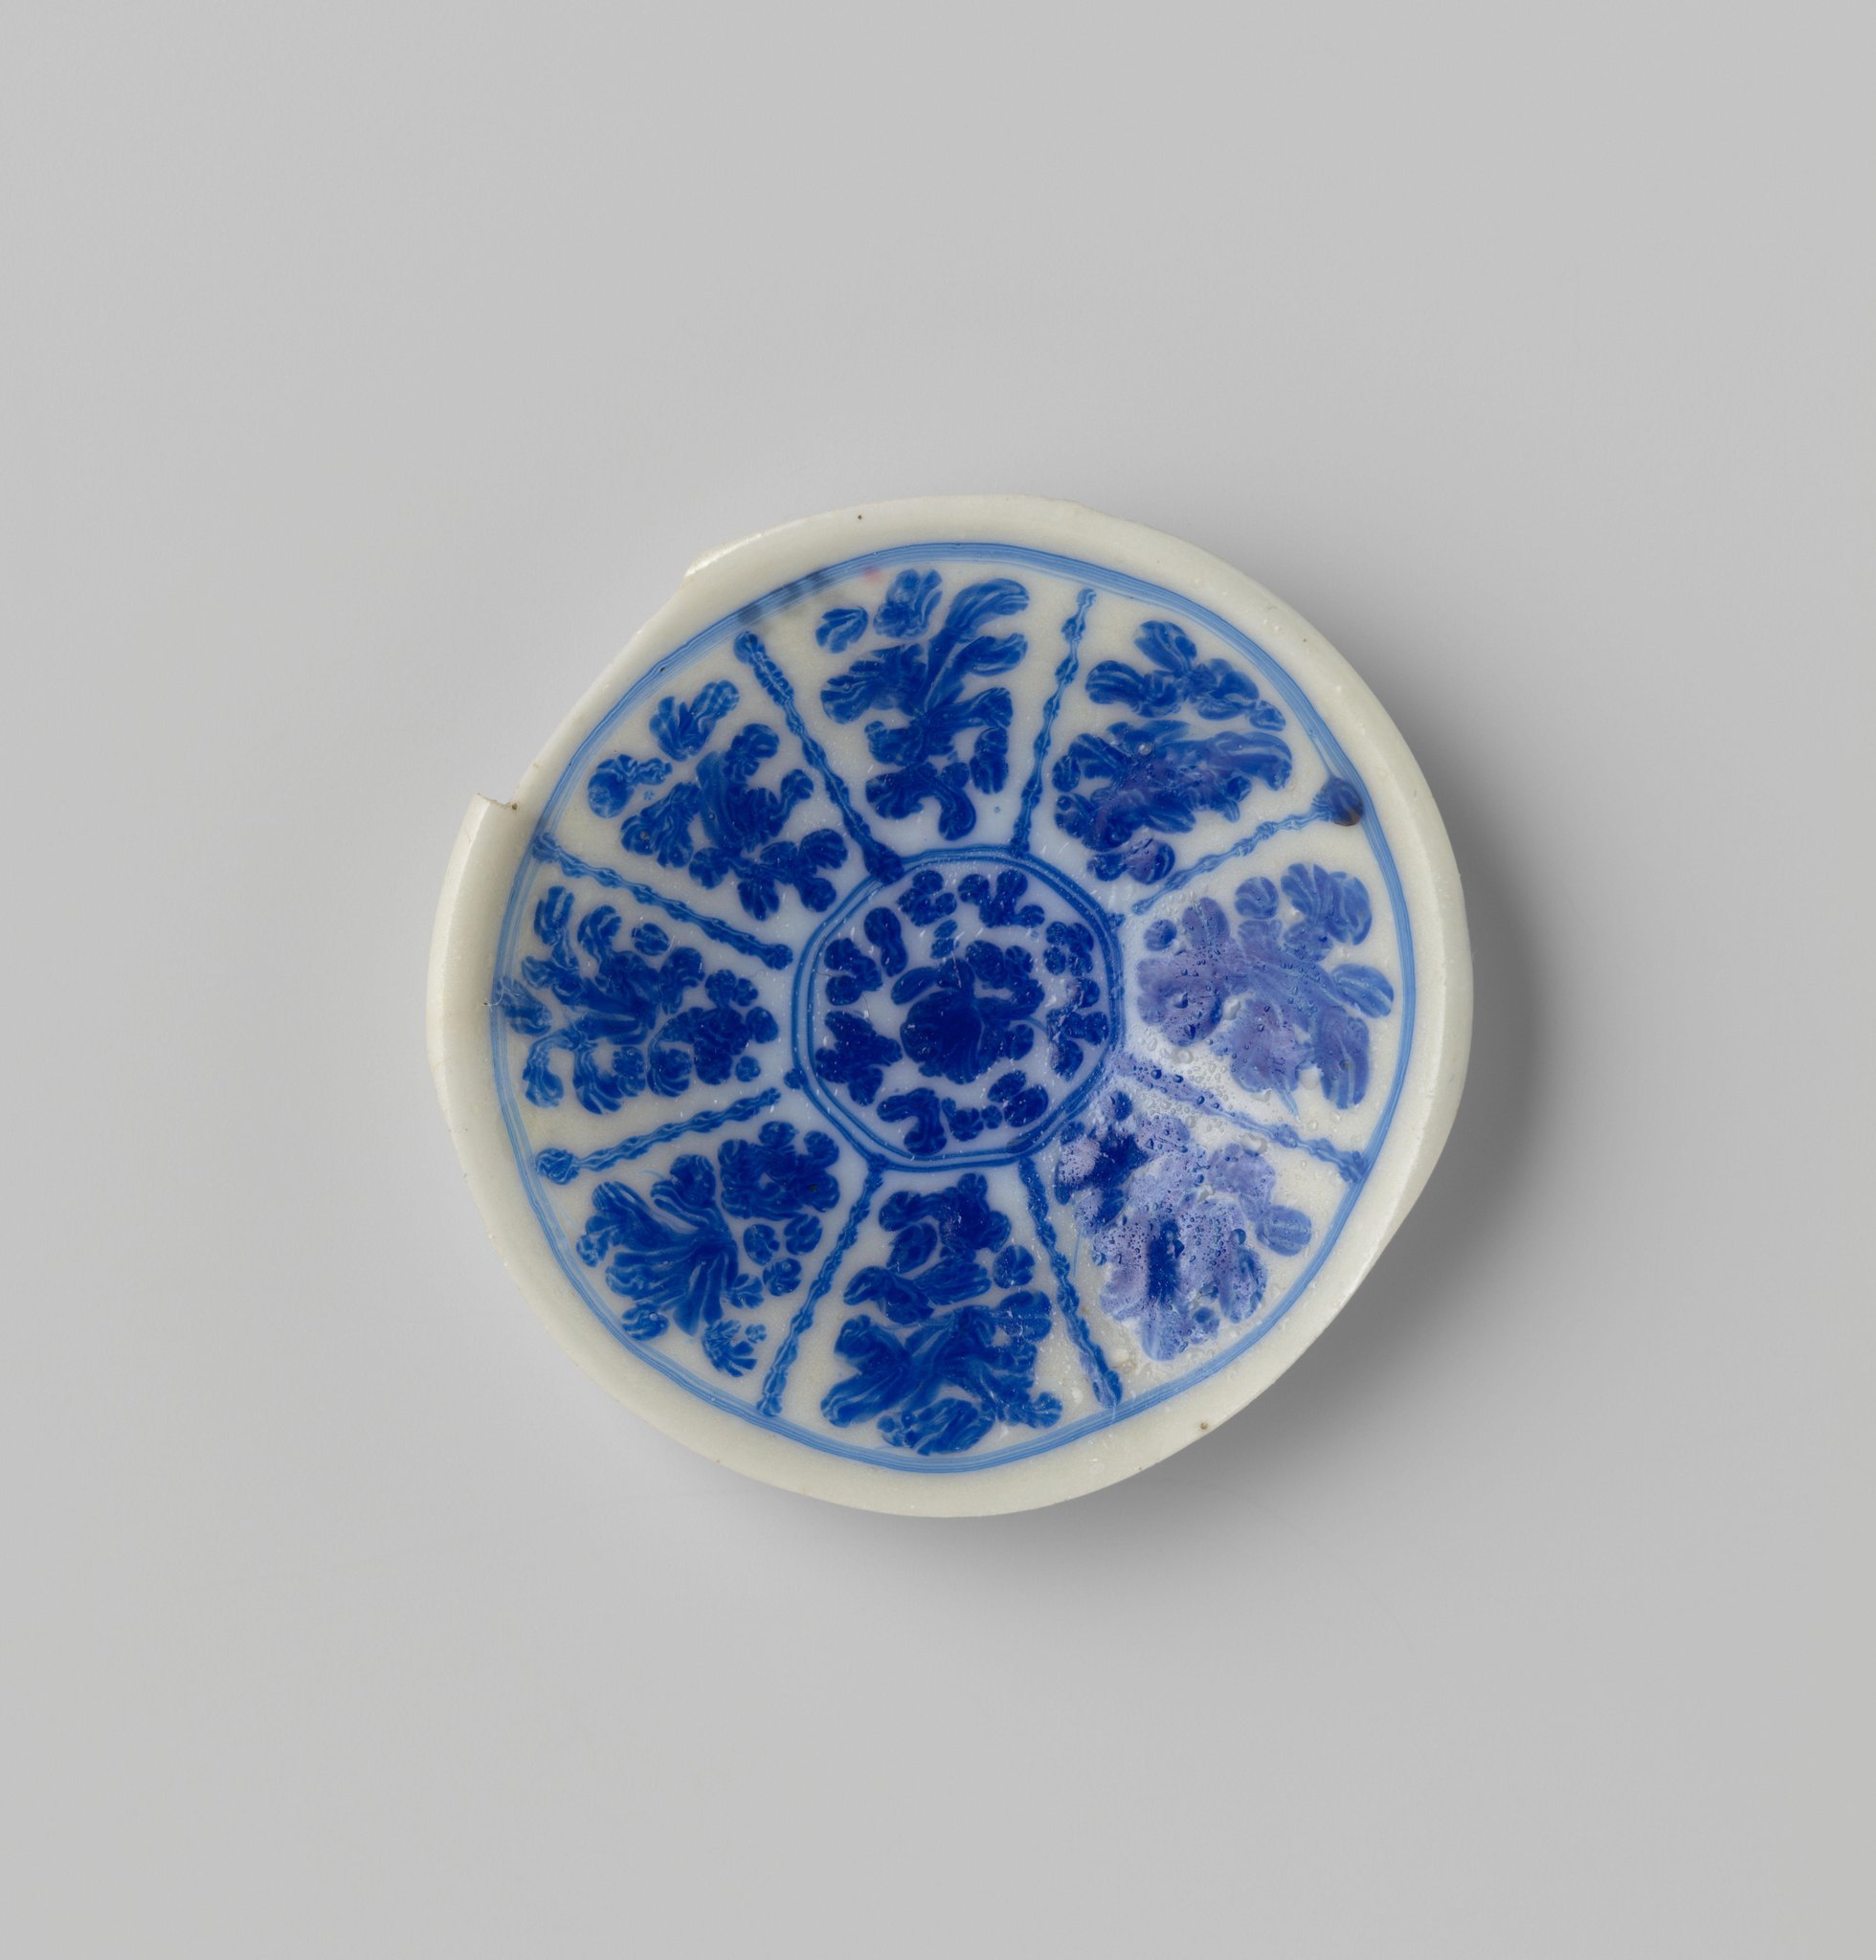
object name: platter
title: Schotel van melkglas met blauwe emailverf beschildering, imitatie Chinees porselein; bloemmotieven in vakken in Kraakporselein stijl, oorspronkelijk ook dubbelwandige schotel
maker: Anonymous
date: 1675-1710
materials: glass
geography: amsterdam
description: Schotel van melkglas met blauwe emailverf beschildering, imitatie Chinees blauw porselein met decoratie van bloemmotieven in vakken in Kraakporselein stijl; oorspronkelijk ook een dubbelwandige schotel, met gladde rand.